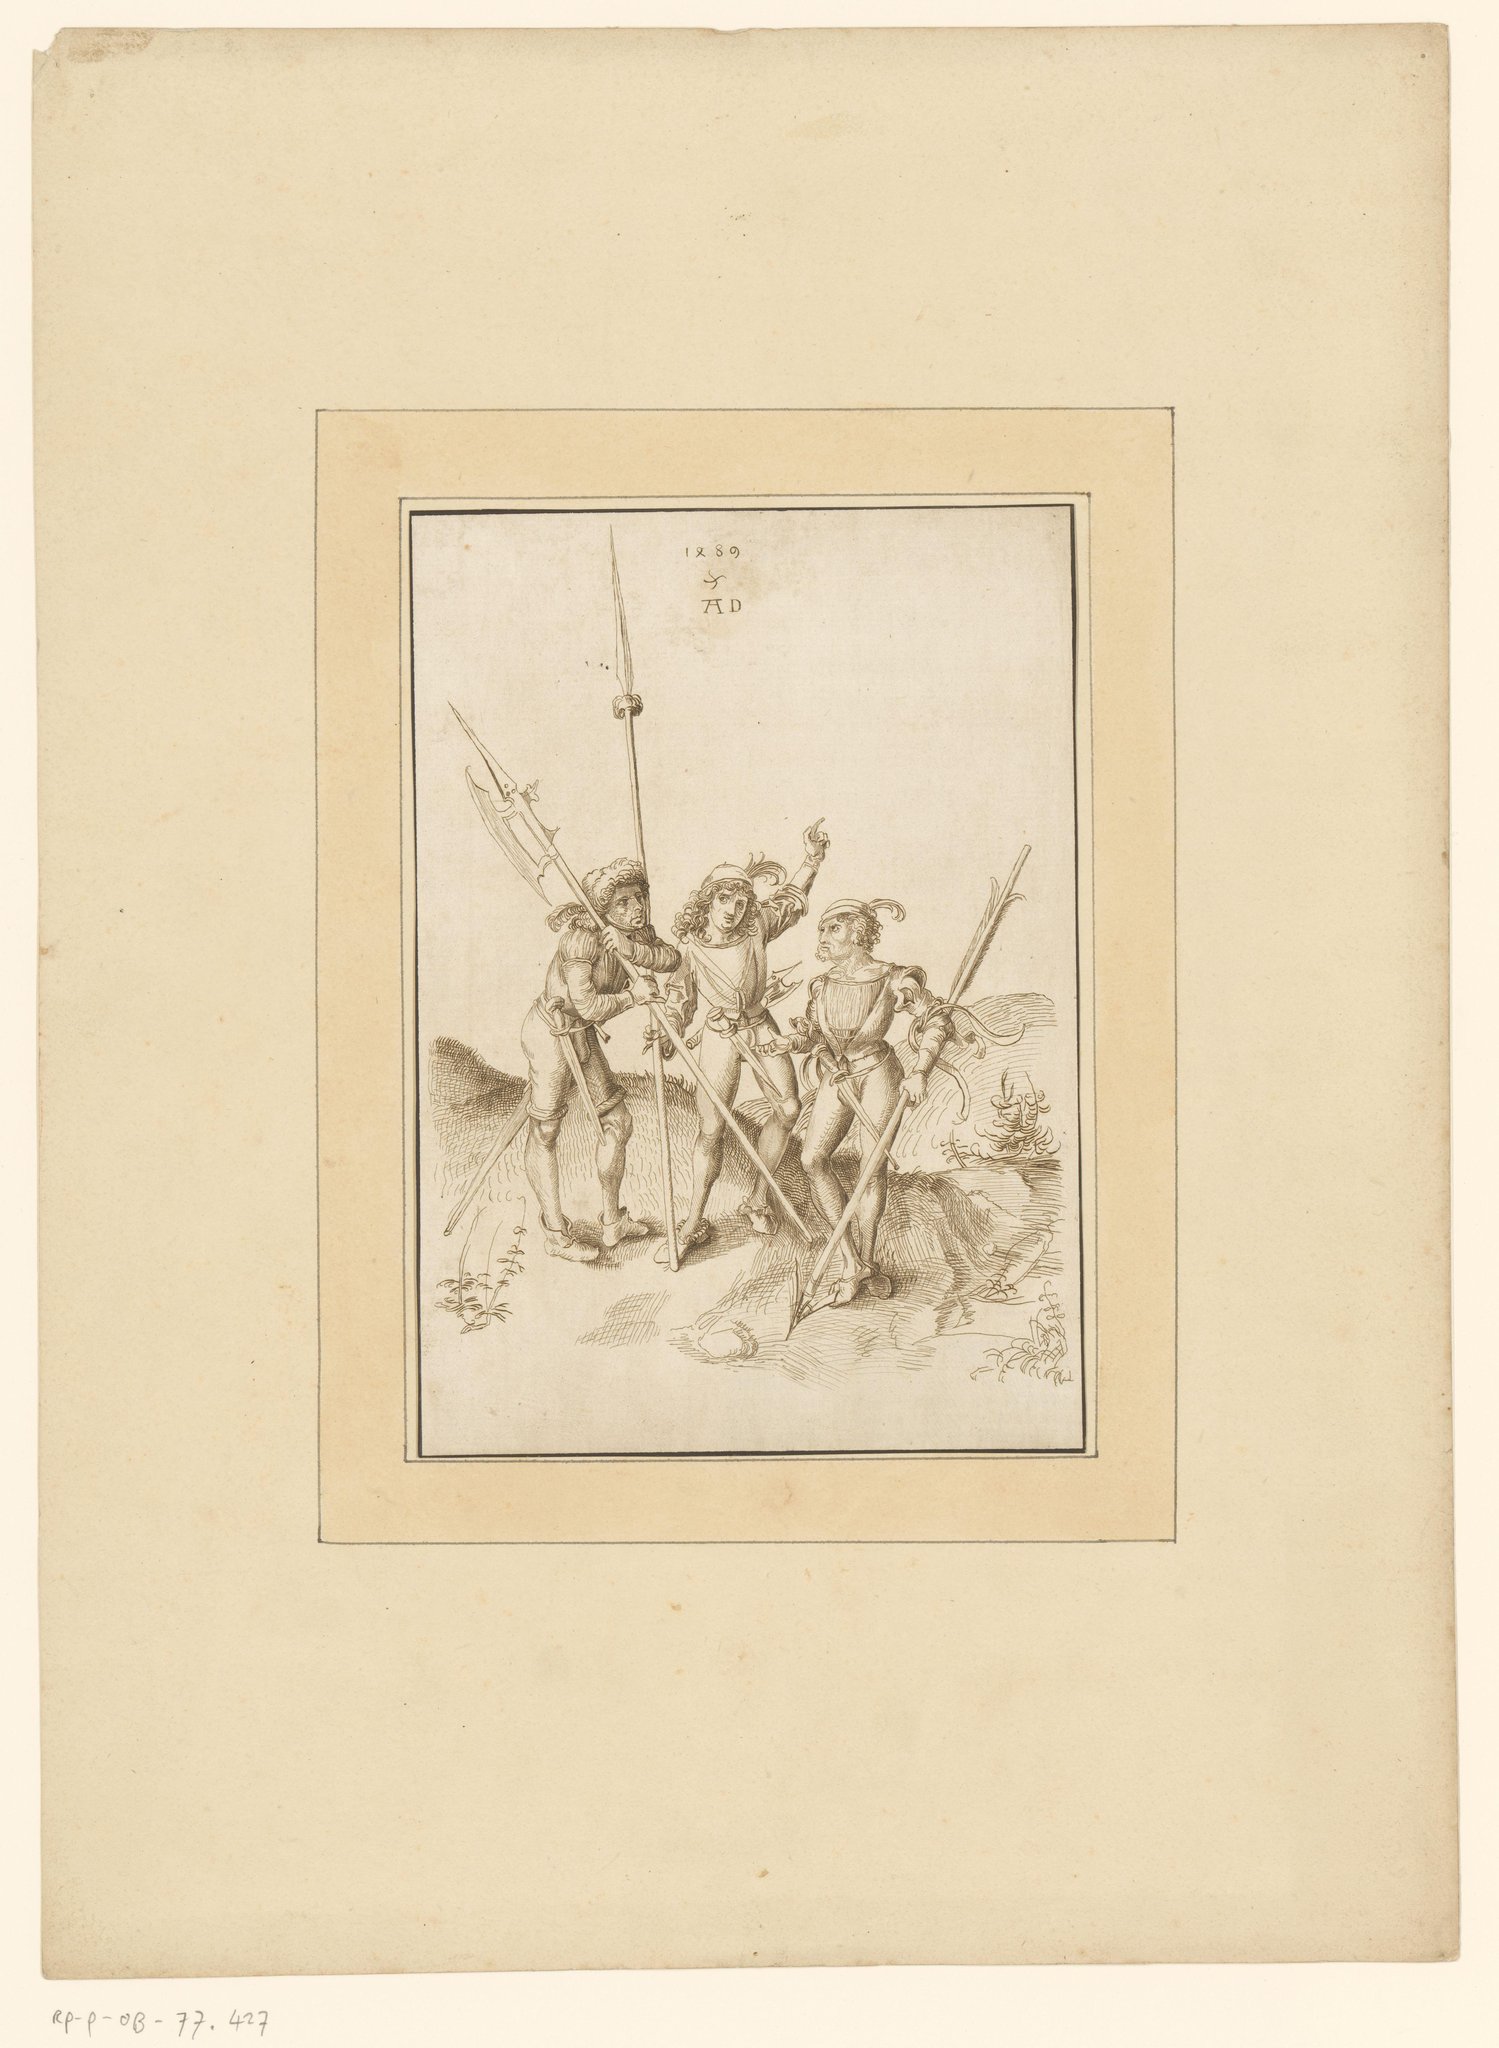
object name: print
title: Rütlischwur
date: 1757-1794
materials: paper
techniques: etching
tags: revolutionaries taking the oath, helved weapons, polearms (for striking, hacking, thrusting)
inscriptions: collector's mark: Lugt 2228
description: Nummer 1 uit het prentenalbum 'Dessins des meilleurs Peintres d'Italie, d'Allemagne, et des Pays-Bas, Tirés de divers célebres Cabinets. Gravés d'apres les Originaux de même grandeur par Jean Théophile Prestel'. Neurenberg: J.G. Prestel, 1783.